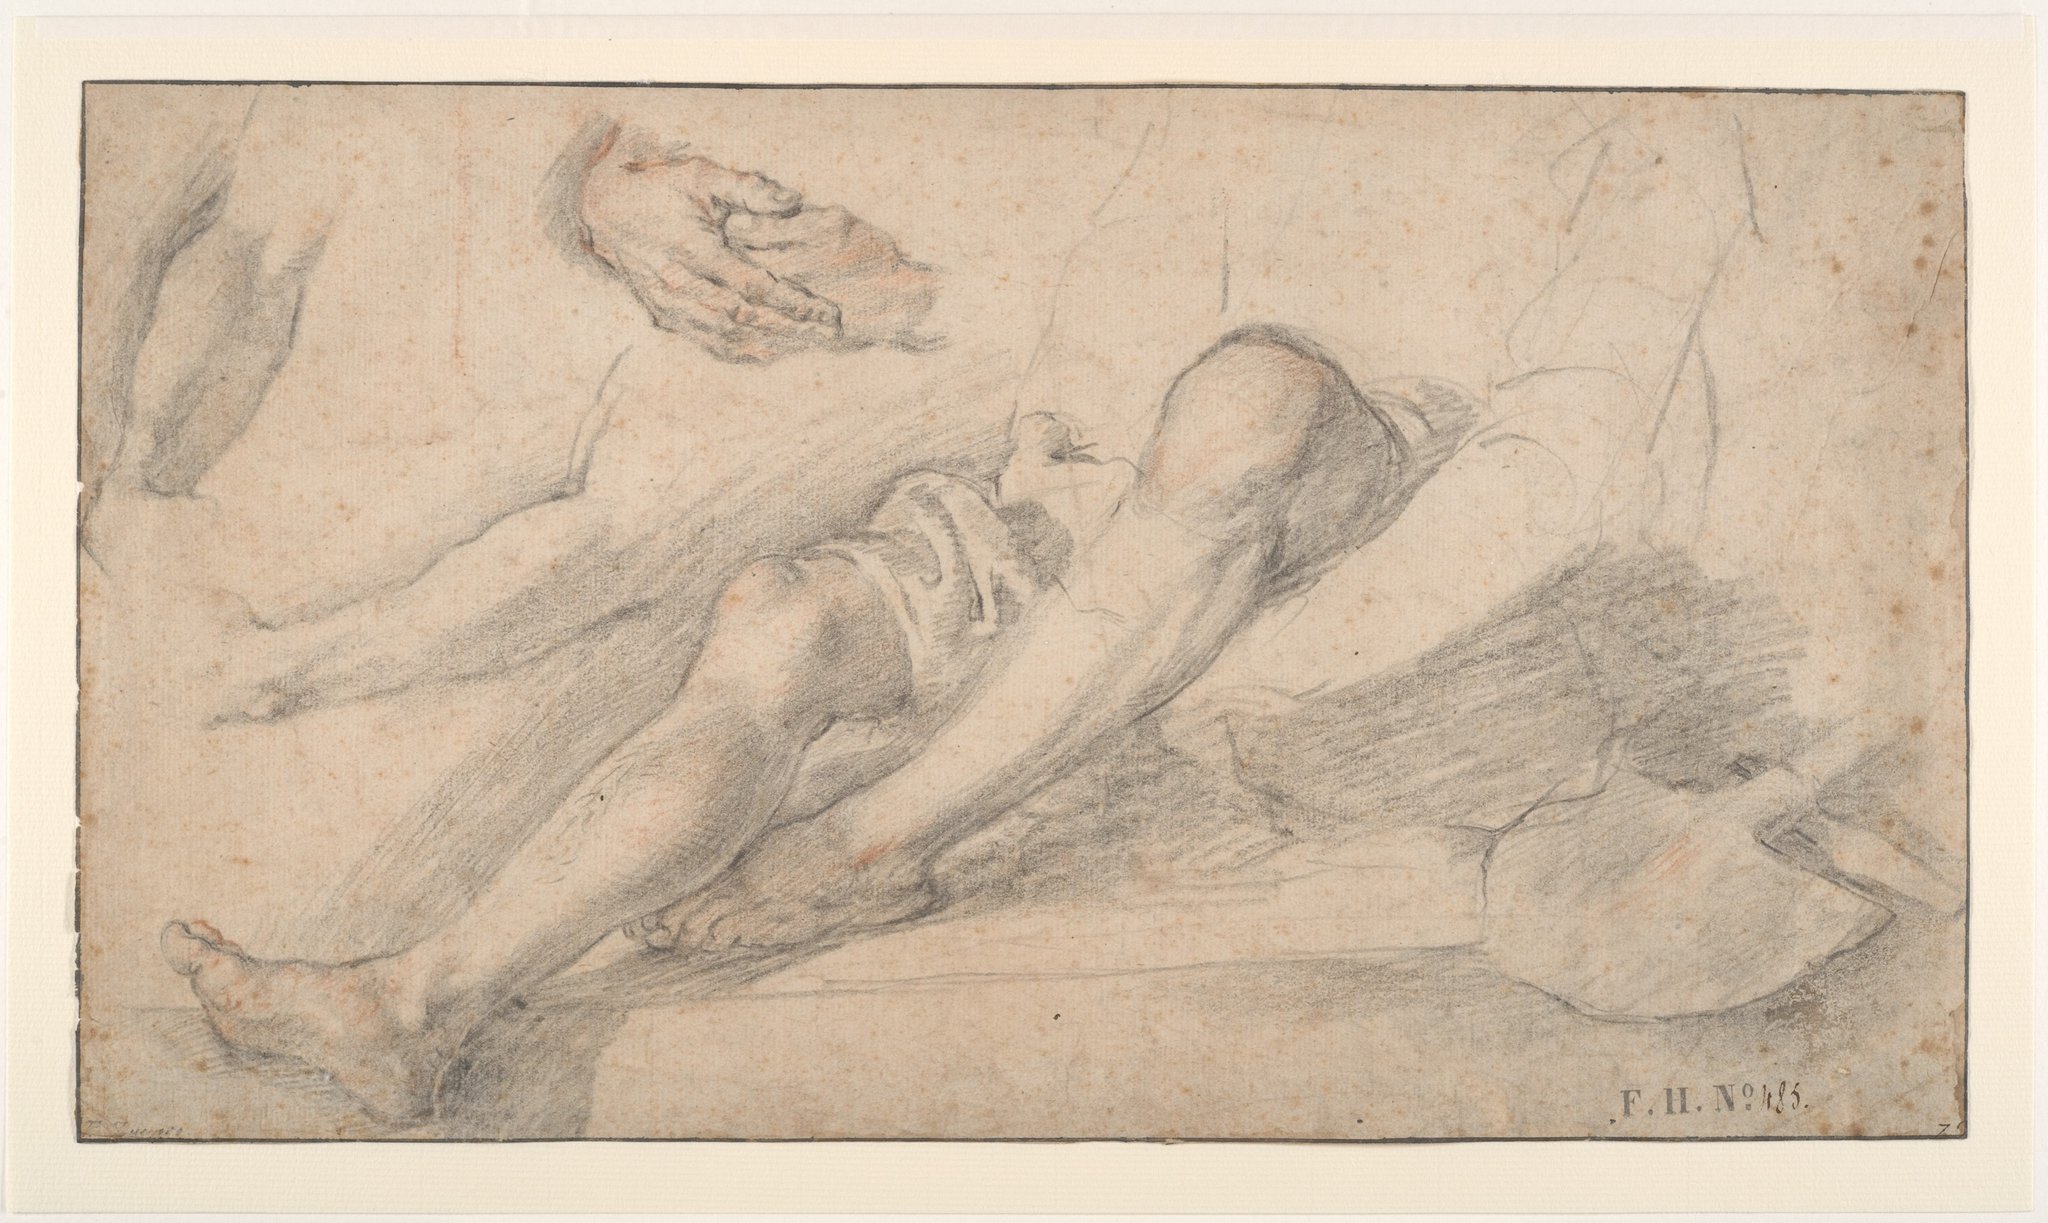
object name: drawing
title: Studies for a Seated Figure of a Man with a Shovel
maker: bernardino poccetti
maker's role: artist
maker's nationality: italian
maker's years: 1548-1612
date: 1603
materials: chalk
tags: hands,men,legs,tools